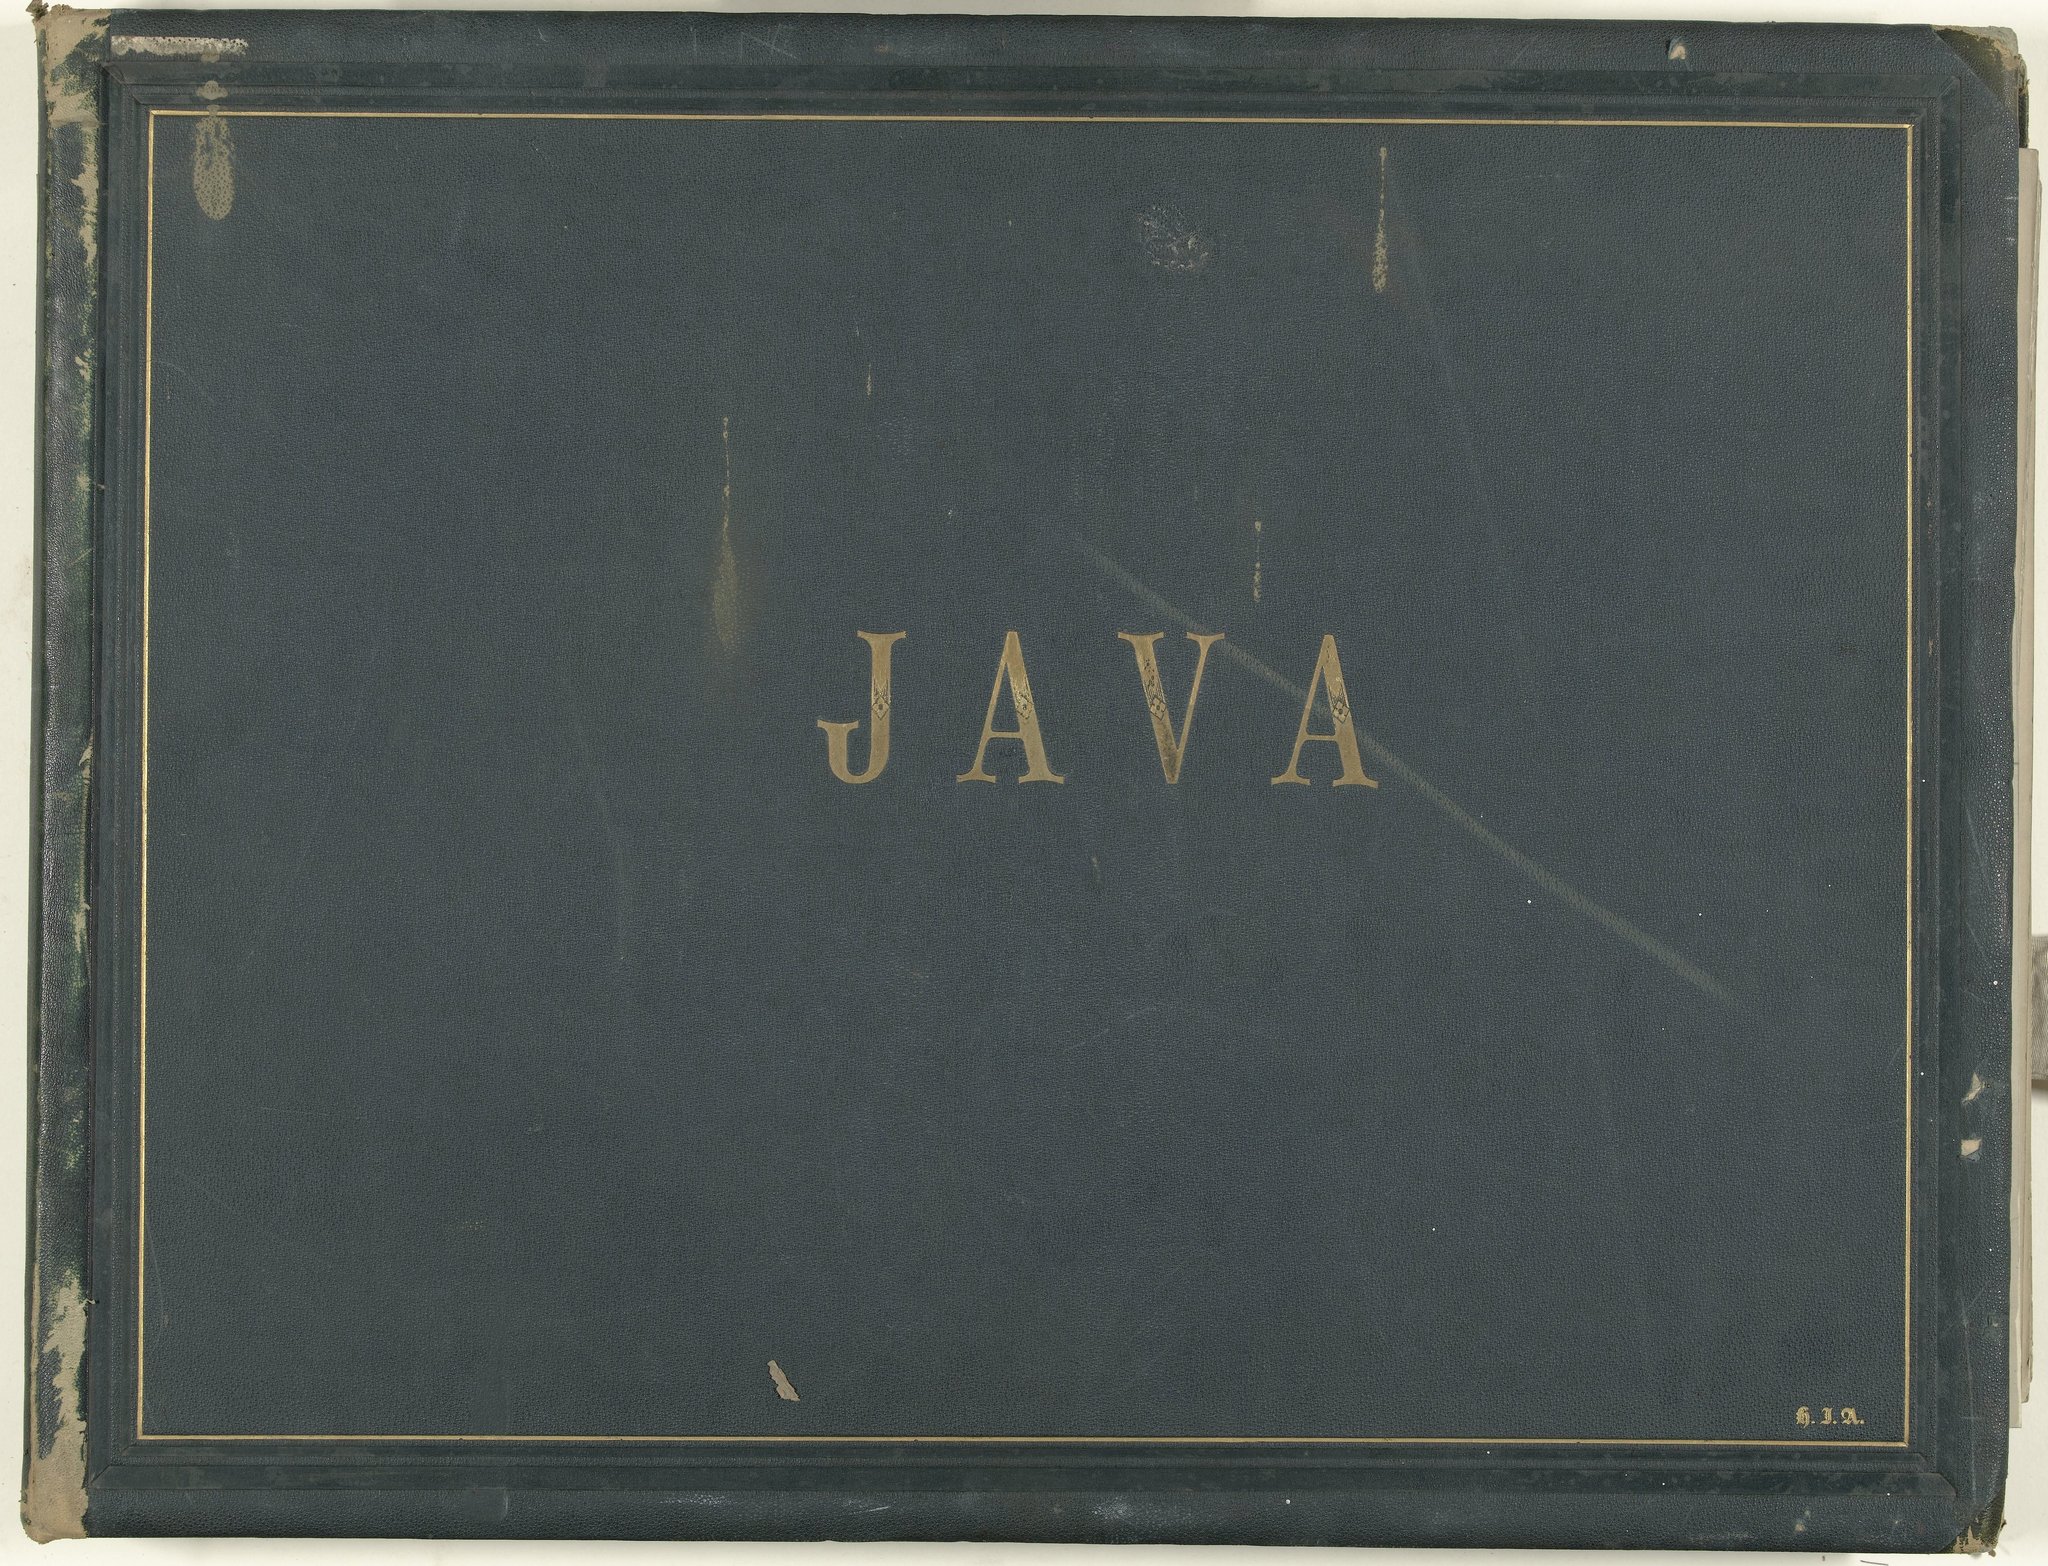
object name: photograph album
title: Java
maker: isidore kinsbergen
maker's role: fotograaf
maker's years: 1821-1905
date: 1864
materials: cardboard, paper, photographic support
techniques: albumen print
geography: java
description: Album Ankersmit I/ Van Kinsbergen met .. foto's van monumenten van Java, waaronder de Borodudur, Indonesië.